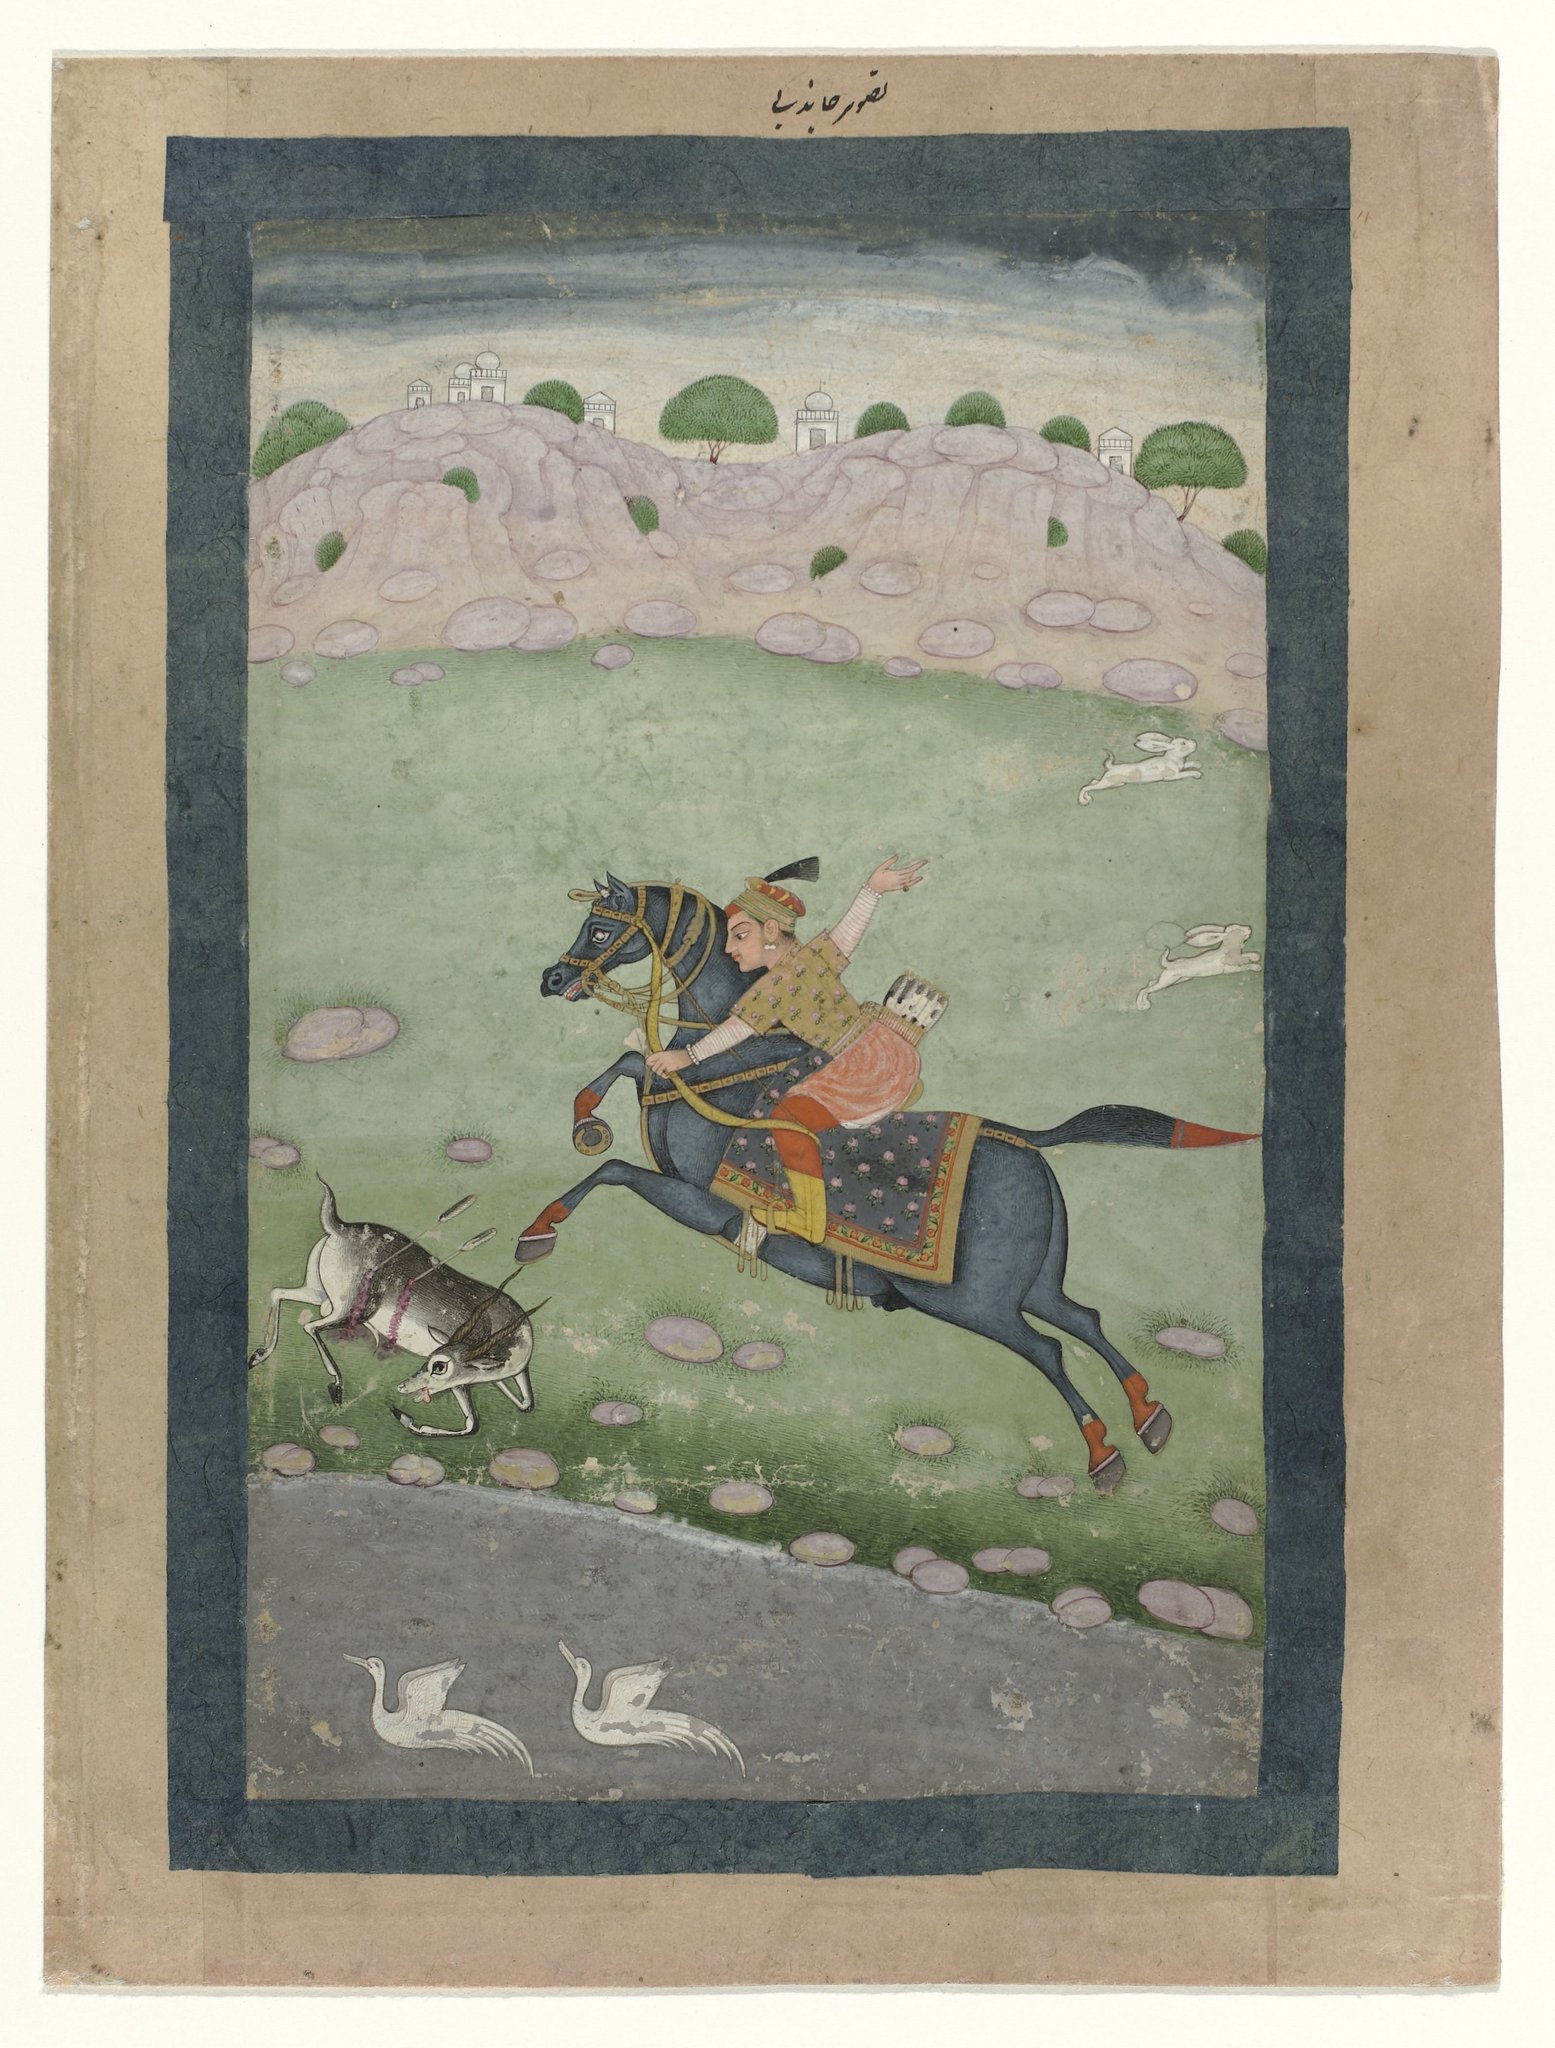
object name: drawing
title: Ruiter te paard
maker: Anonymous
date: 1750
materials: paper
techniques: brush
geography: deccan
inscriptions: inscription